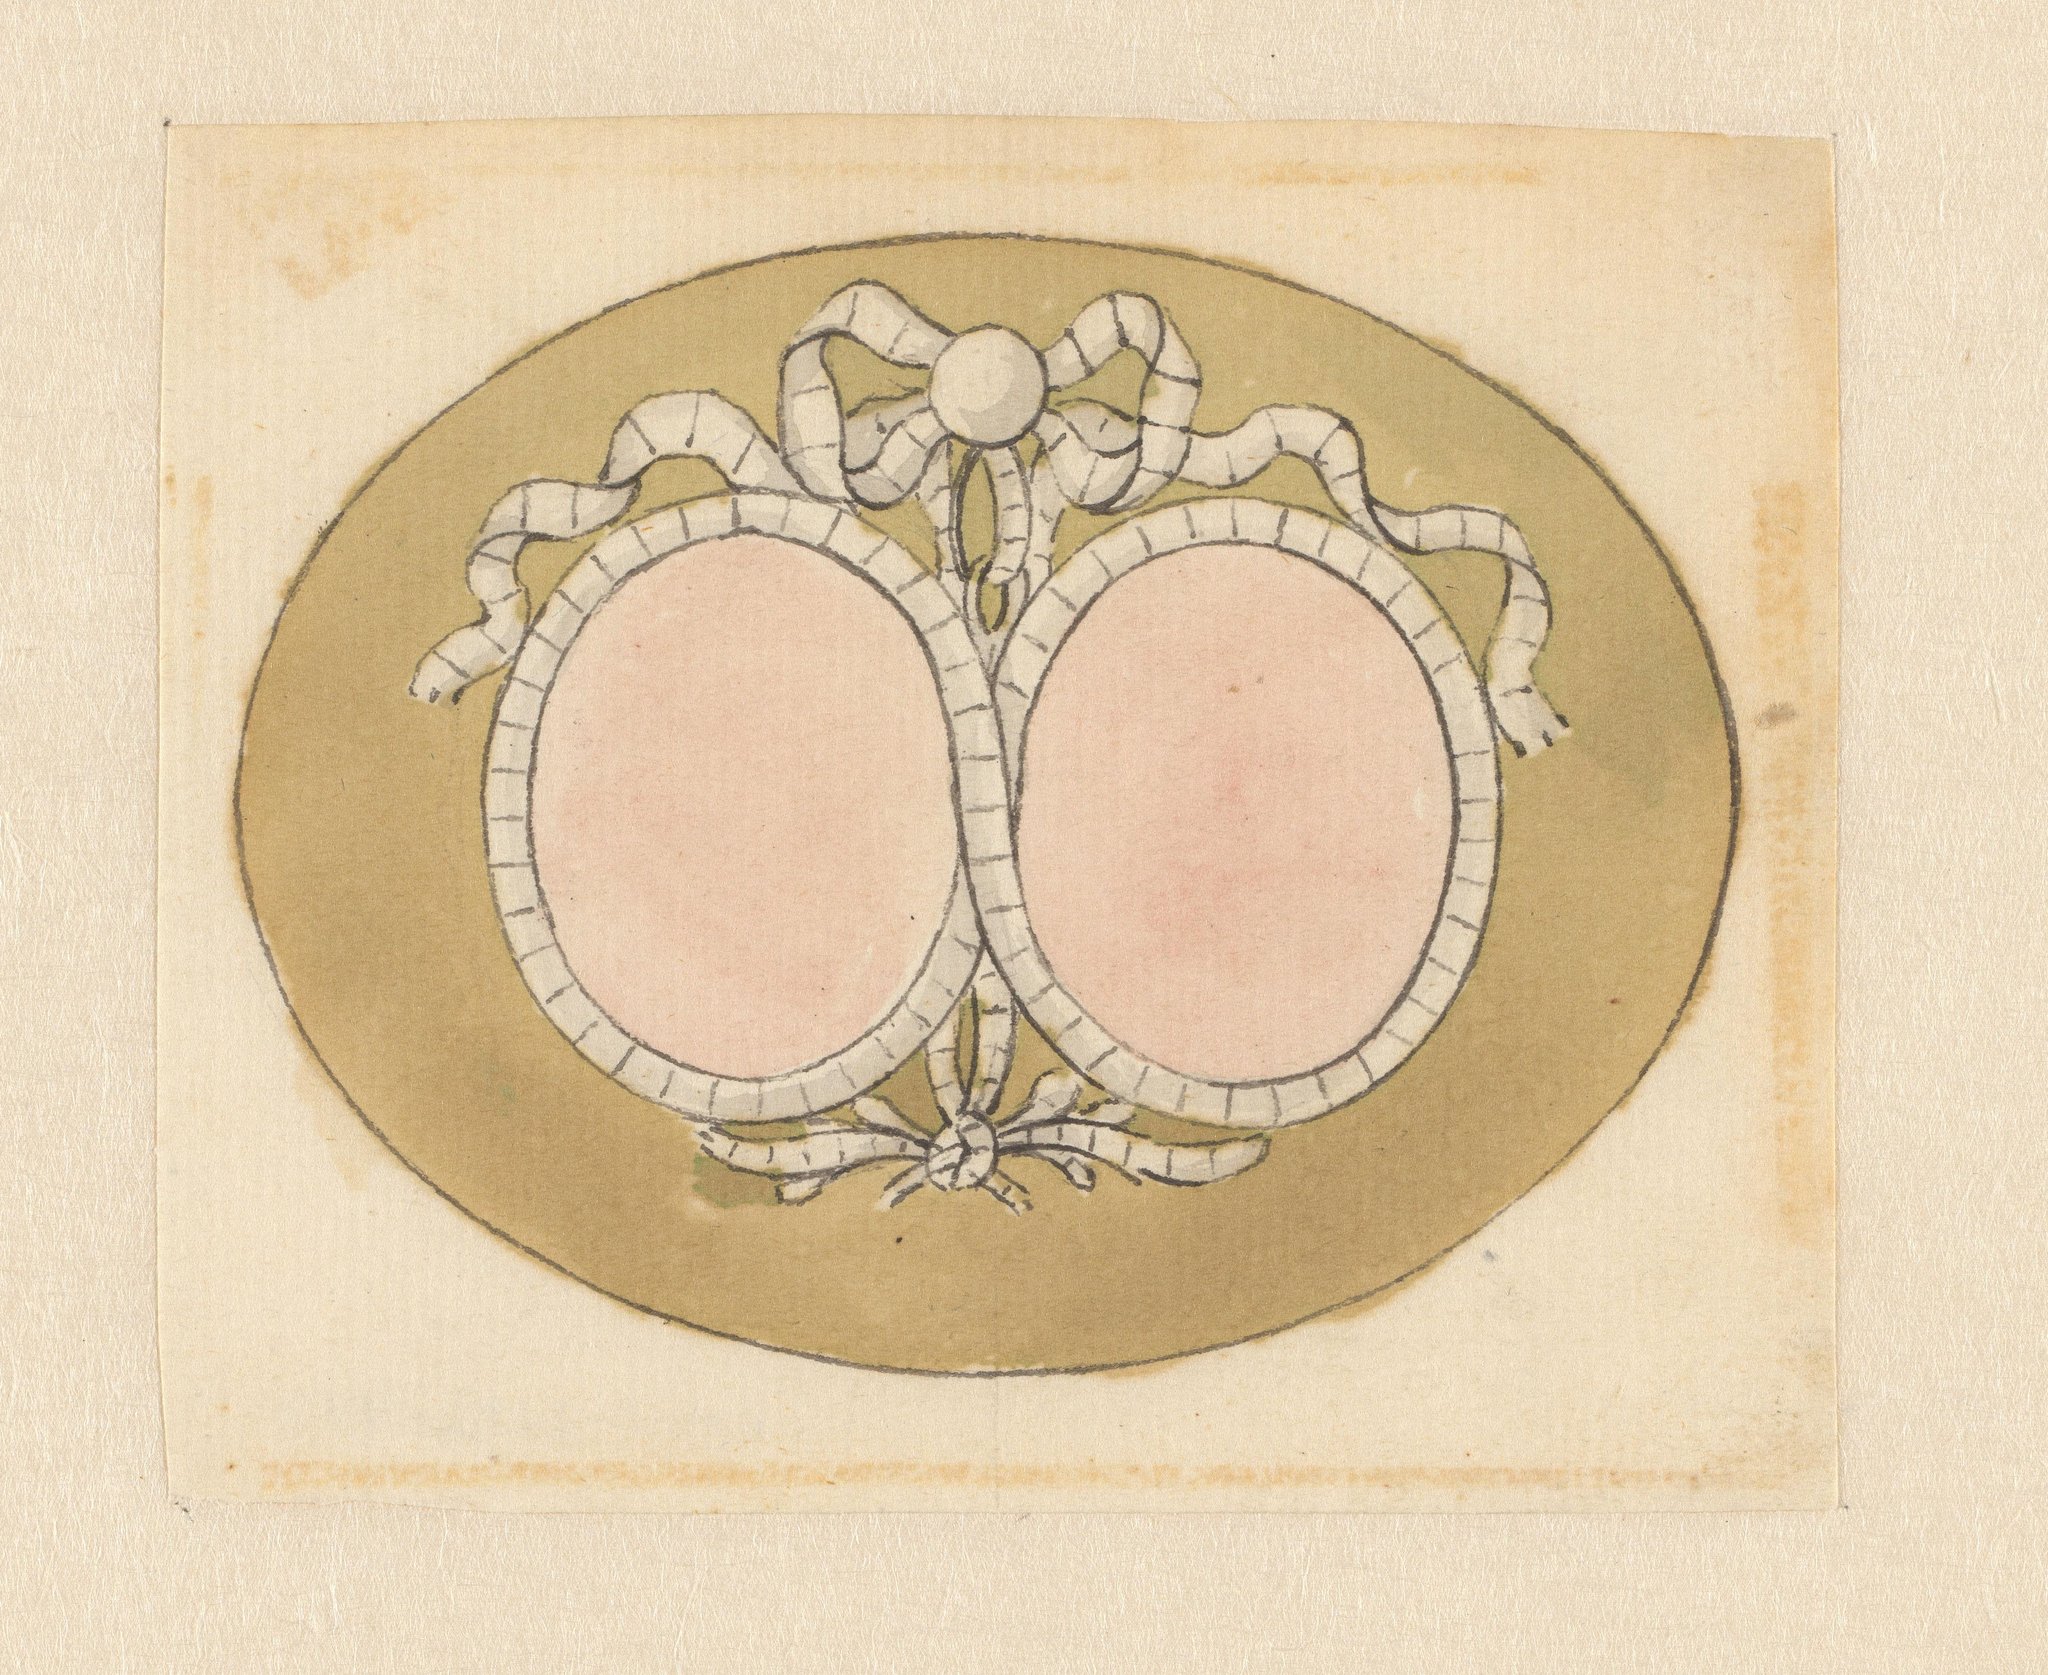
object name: design drawing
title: Snuifdoos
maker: Anonymous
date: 1770-1785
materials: graphite, ink, paper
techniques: brush, pen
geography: paris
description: Ontwerp voor het deksel van een ovale snuifdoos, met twee ovalen binnen linten van diamanten.